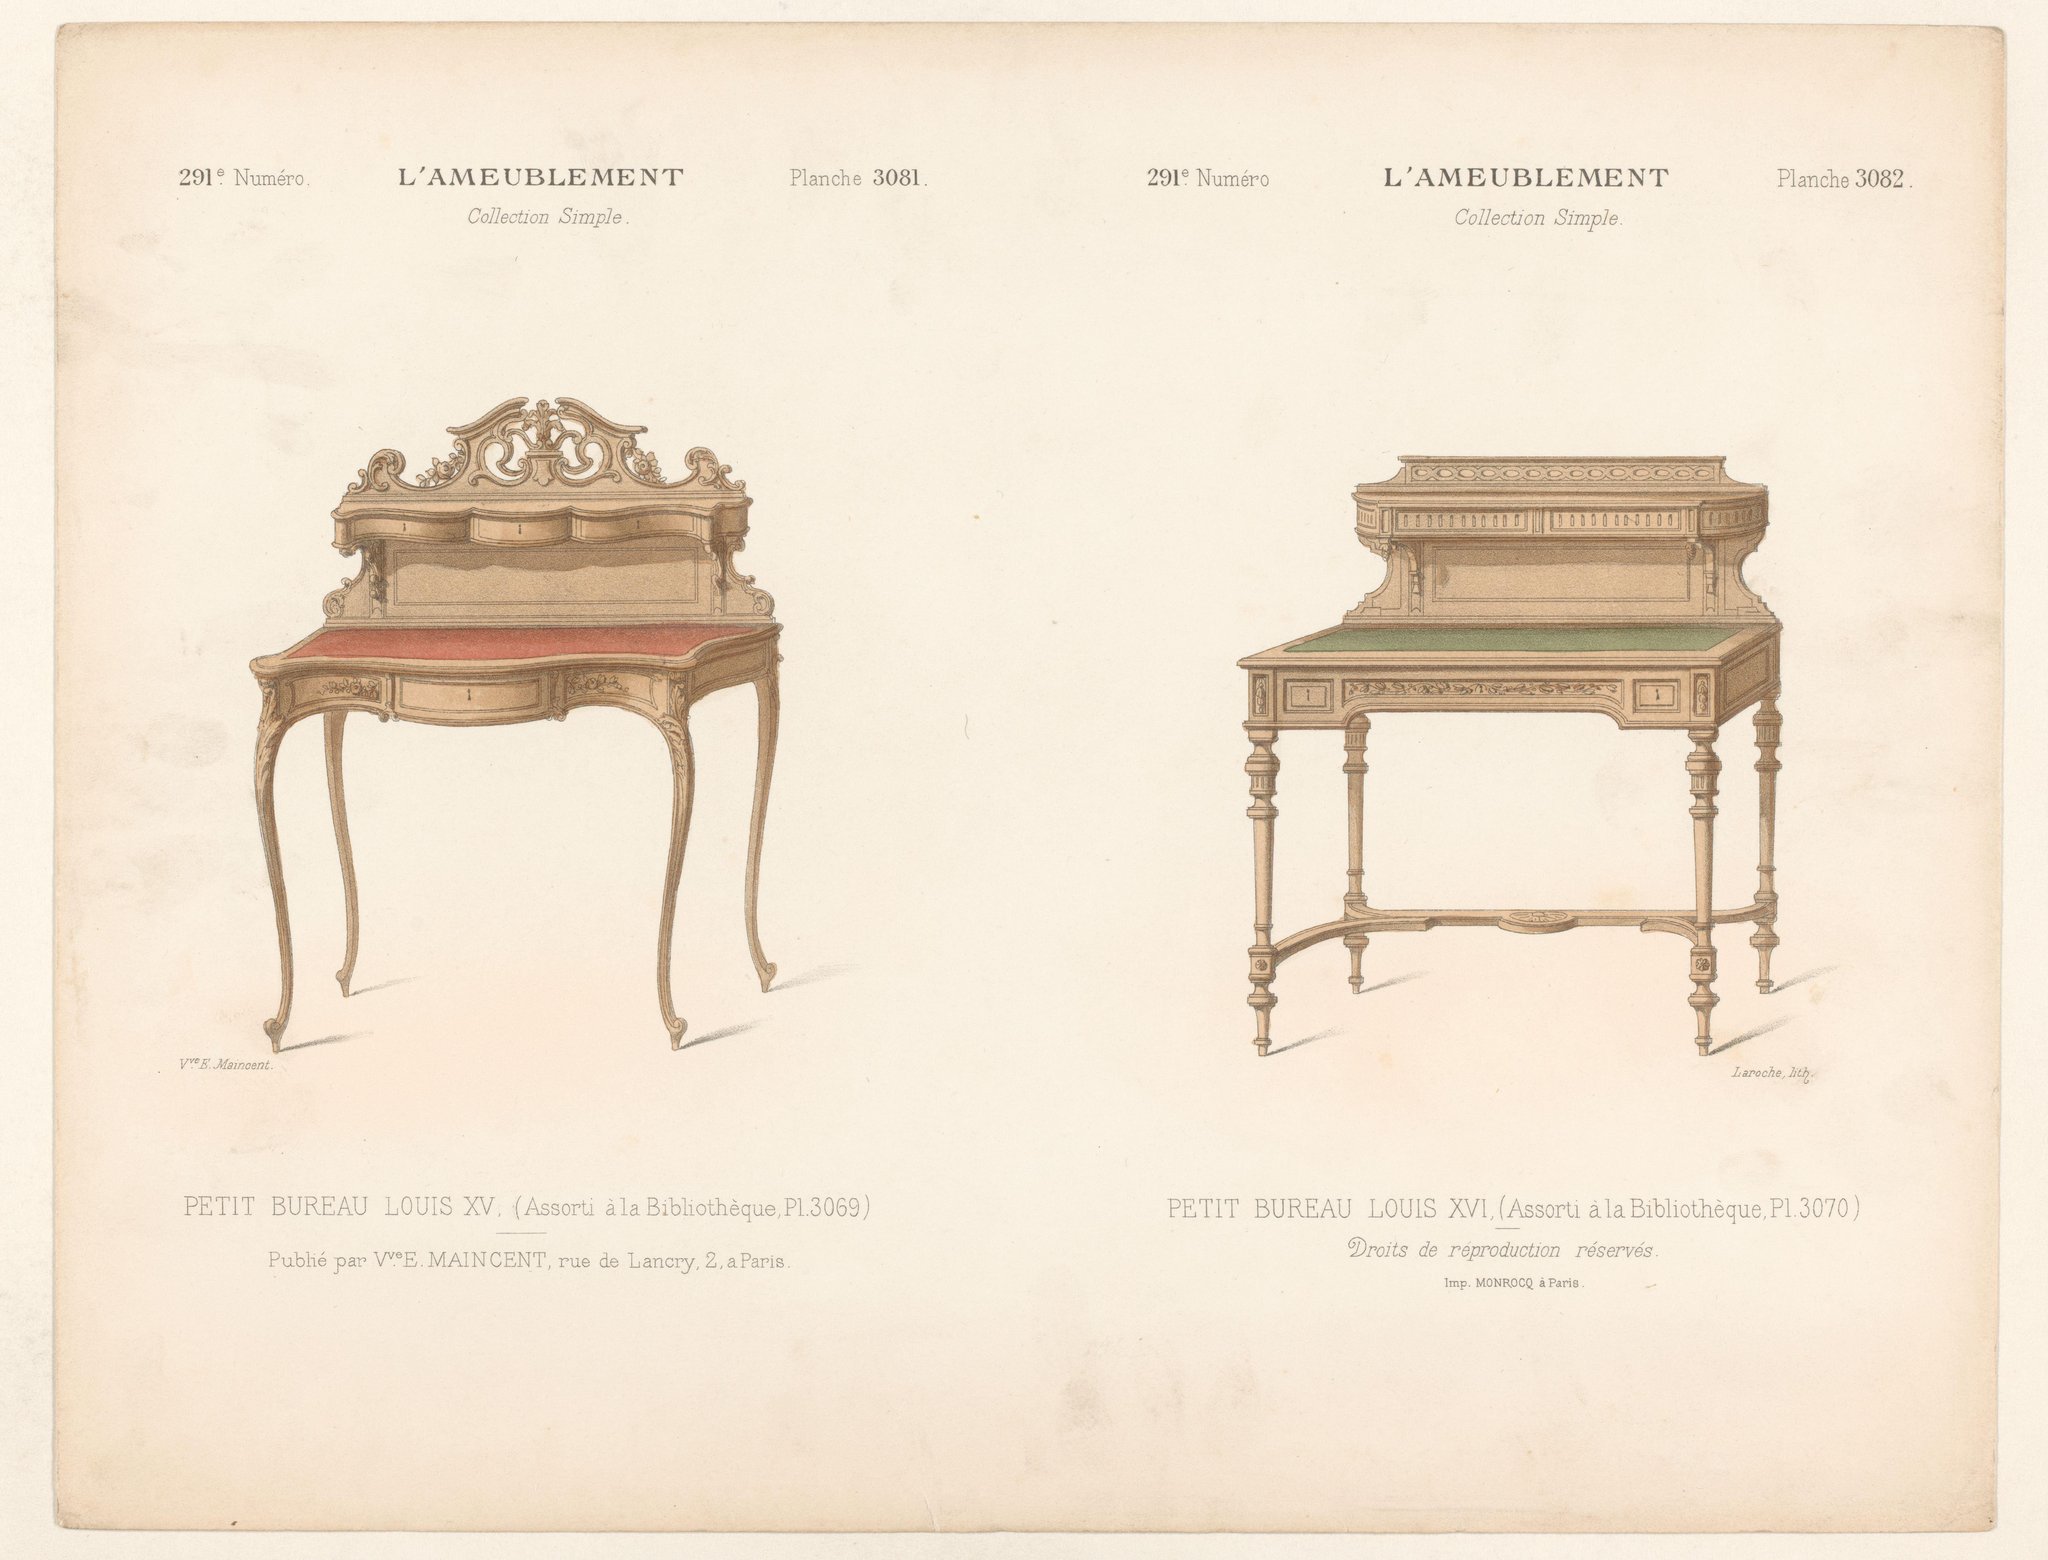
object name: print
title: Petit bureau Louis XV / Petit bureau Louis XVI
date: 1895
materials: paper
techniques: hand coloring, lithograph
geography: paris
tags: writing-table, writing-desk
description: Twee bureaus in de stijlen van Lodewijk XV en Lodewijk XVI. Prent uit 291e Livraison.